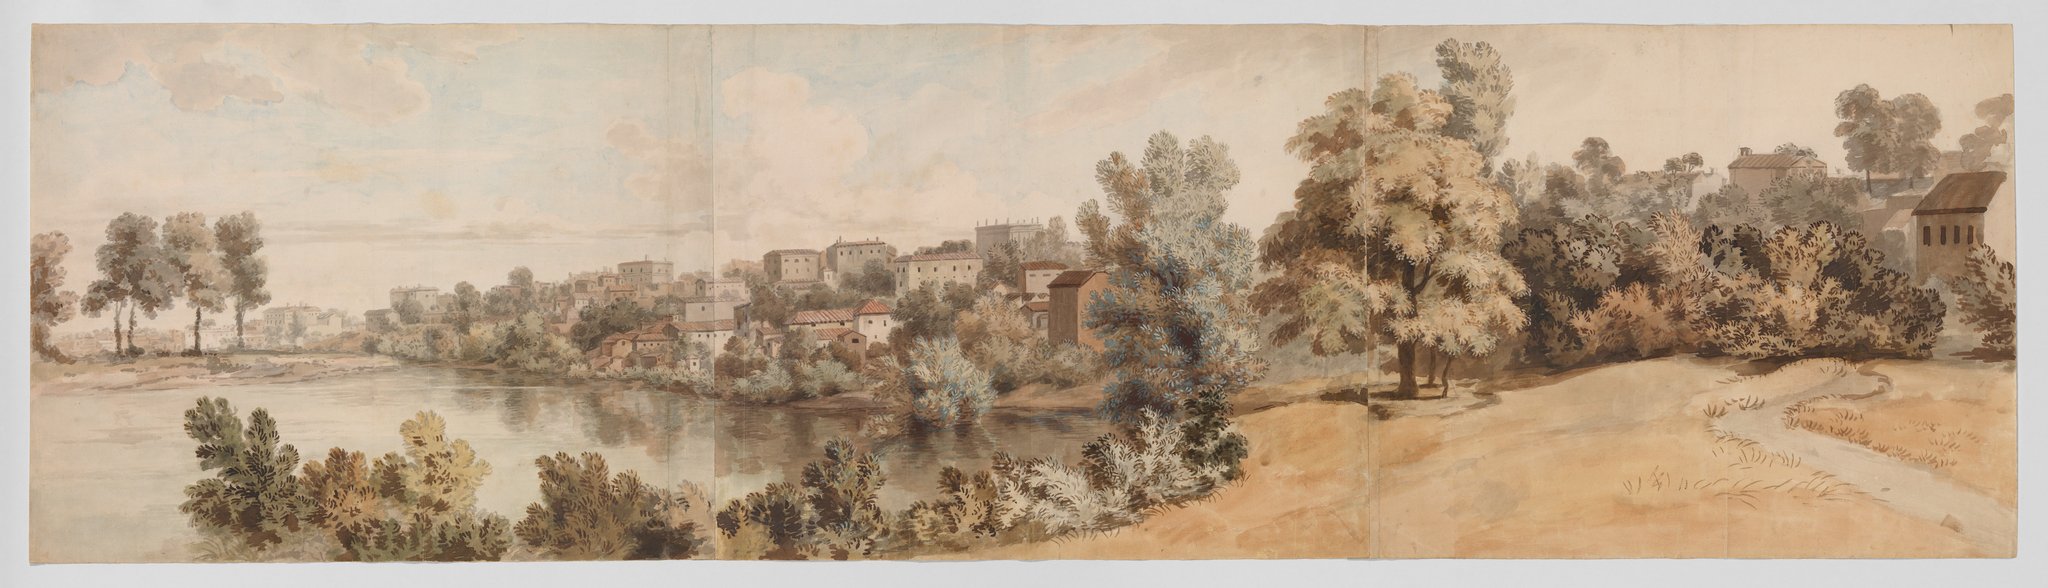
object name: drawing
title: Italianate river landscape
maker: william taverner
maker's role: artist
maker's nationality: british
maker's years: 1700-1772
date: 1750-1760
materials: gouache, graphite, ink, iron, watercolor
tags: rivers,landscapes,trees